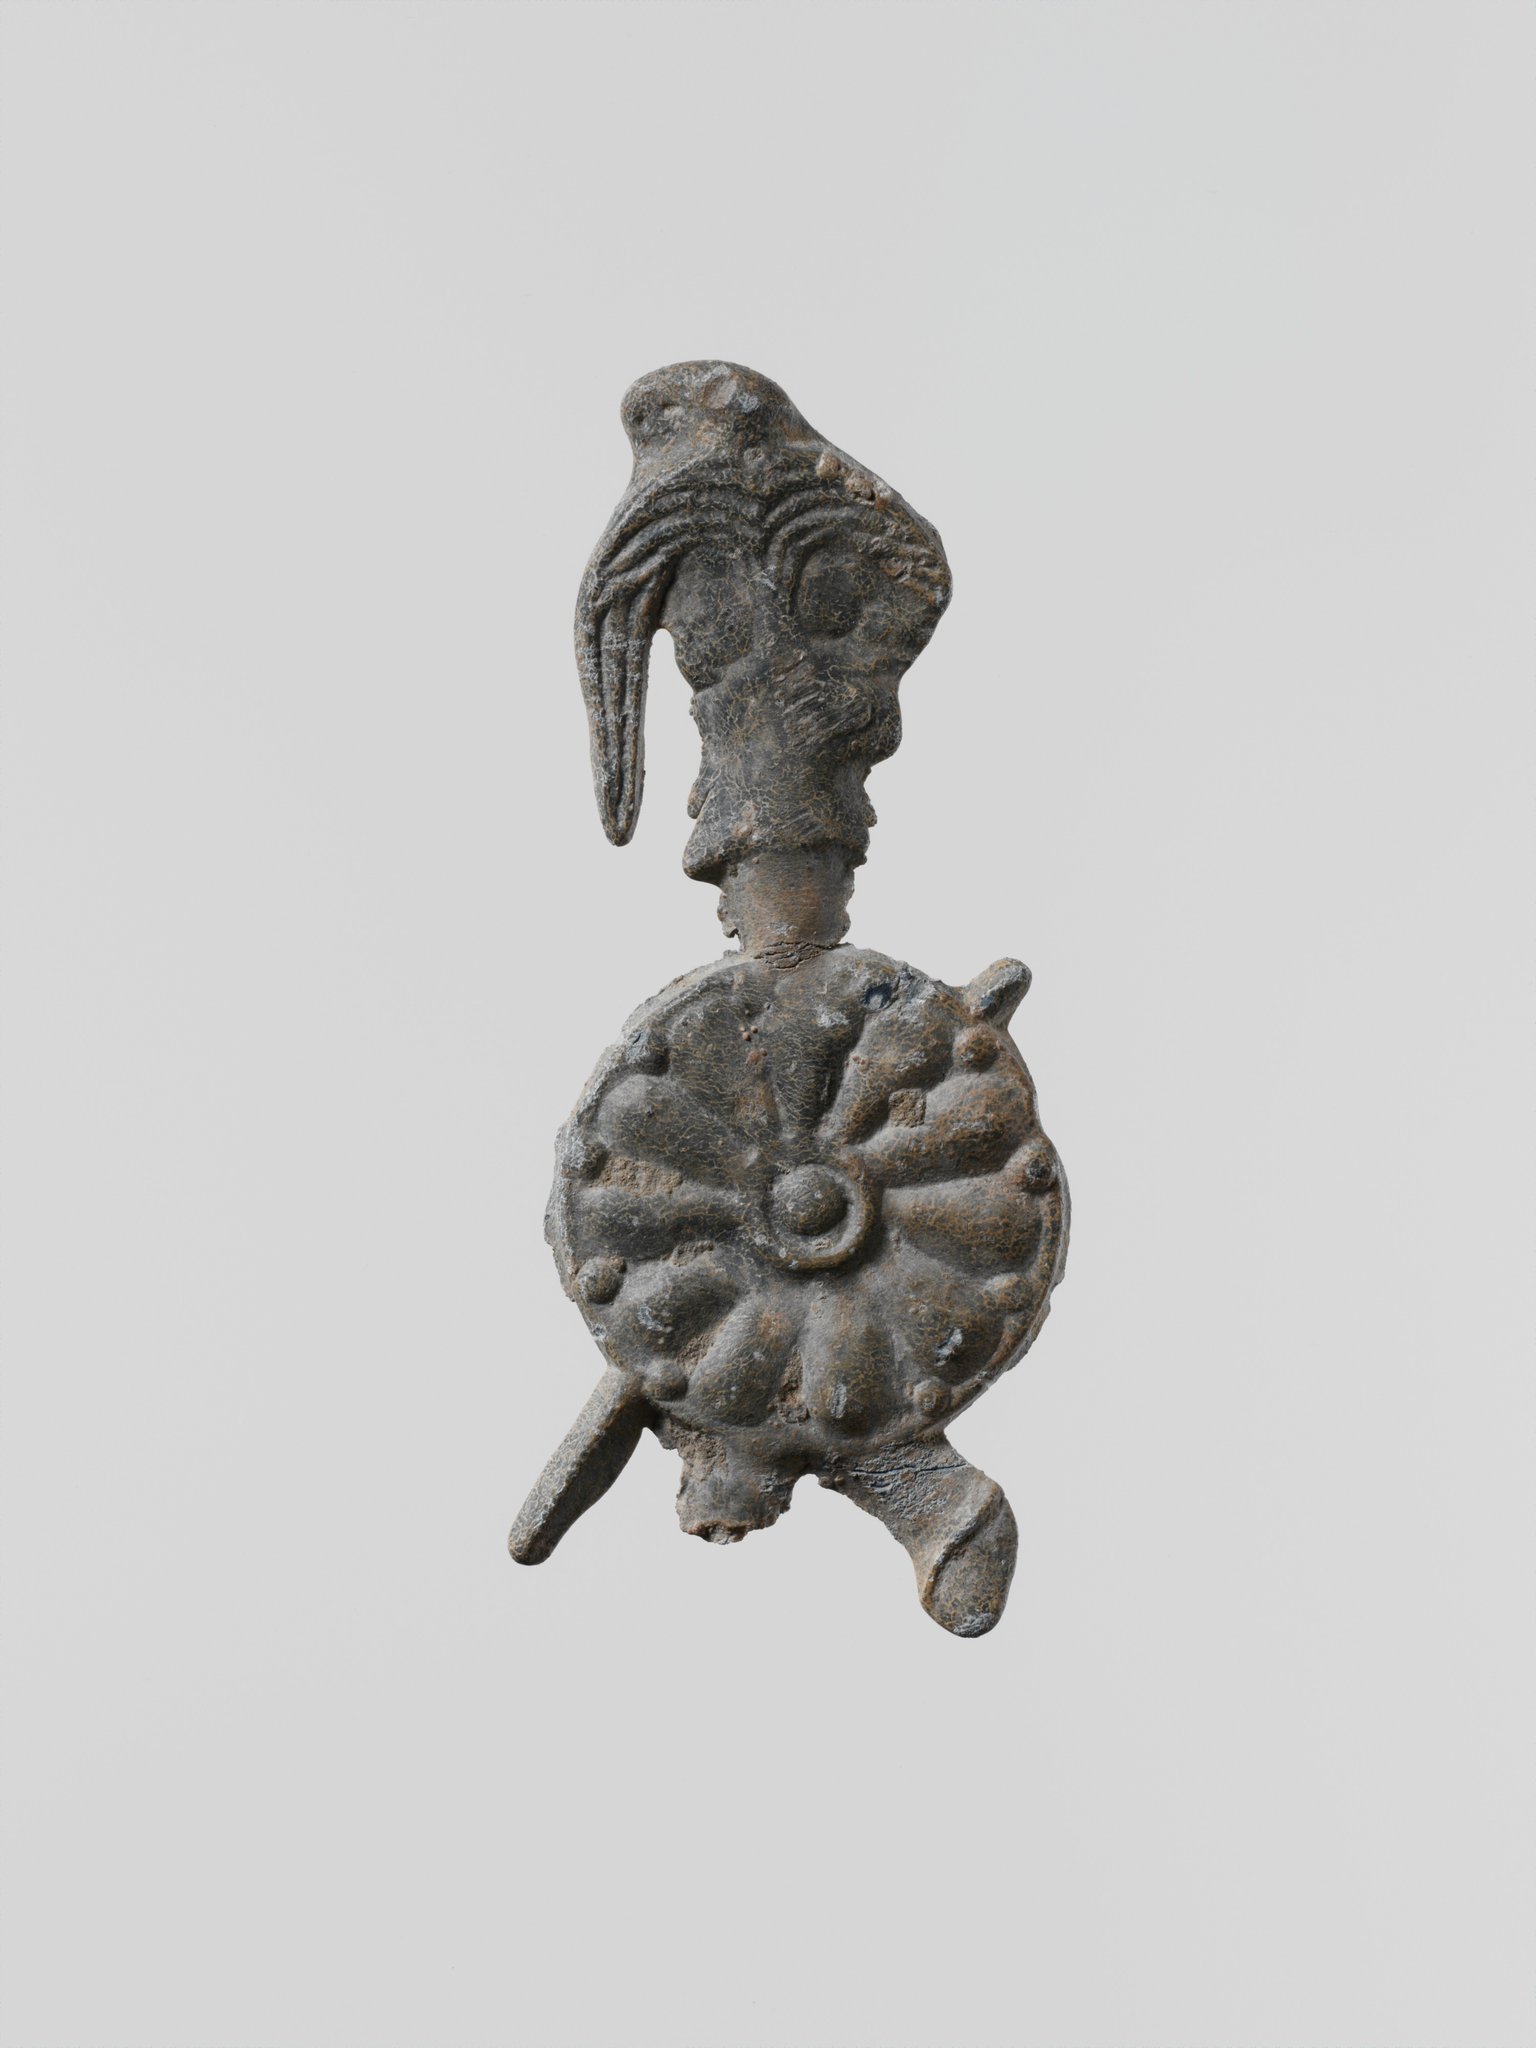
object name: statuette of a warrior, 10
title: Lead figure of a warrior with a helmet, shield, and spear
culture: greek, laconian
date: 600-401 BCE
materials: lead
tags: helmets,shields